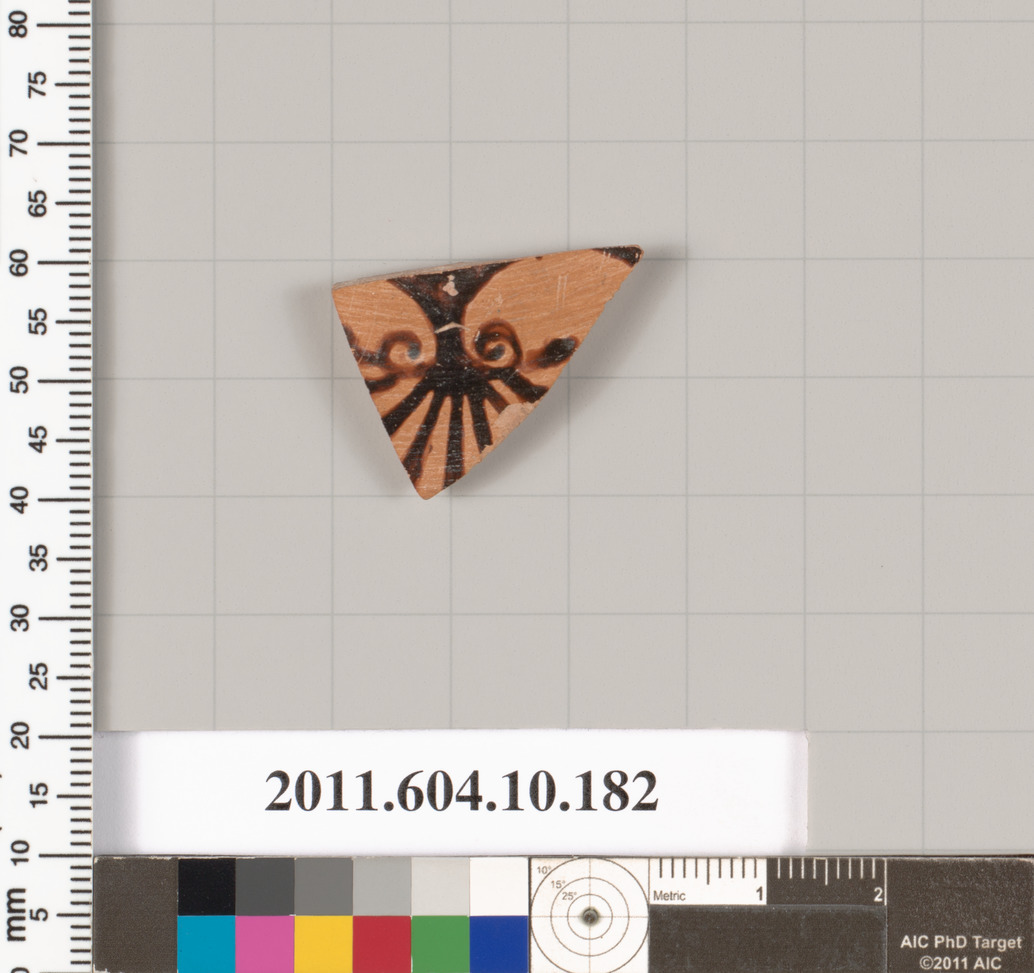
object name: undetermined closed shape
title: Terracotta fragment of a closed shape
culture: etruscan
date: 534-468 BCE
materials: terracotta